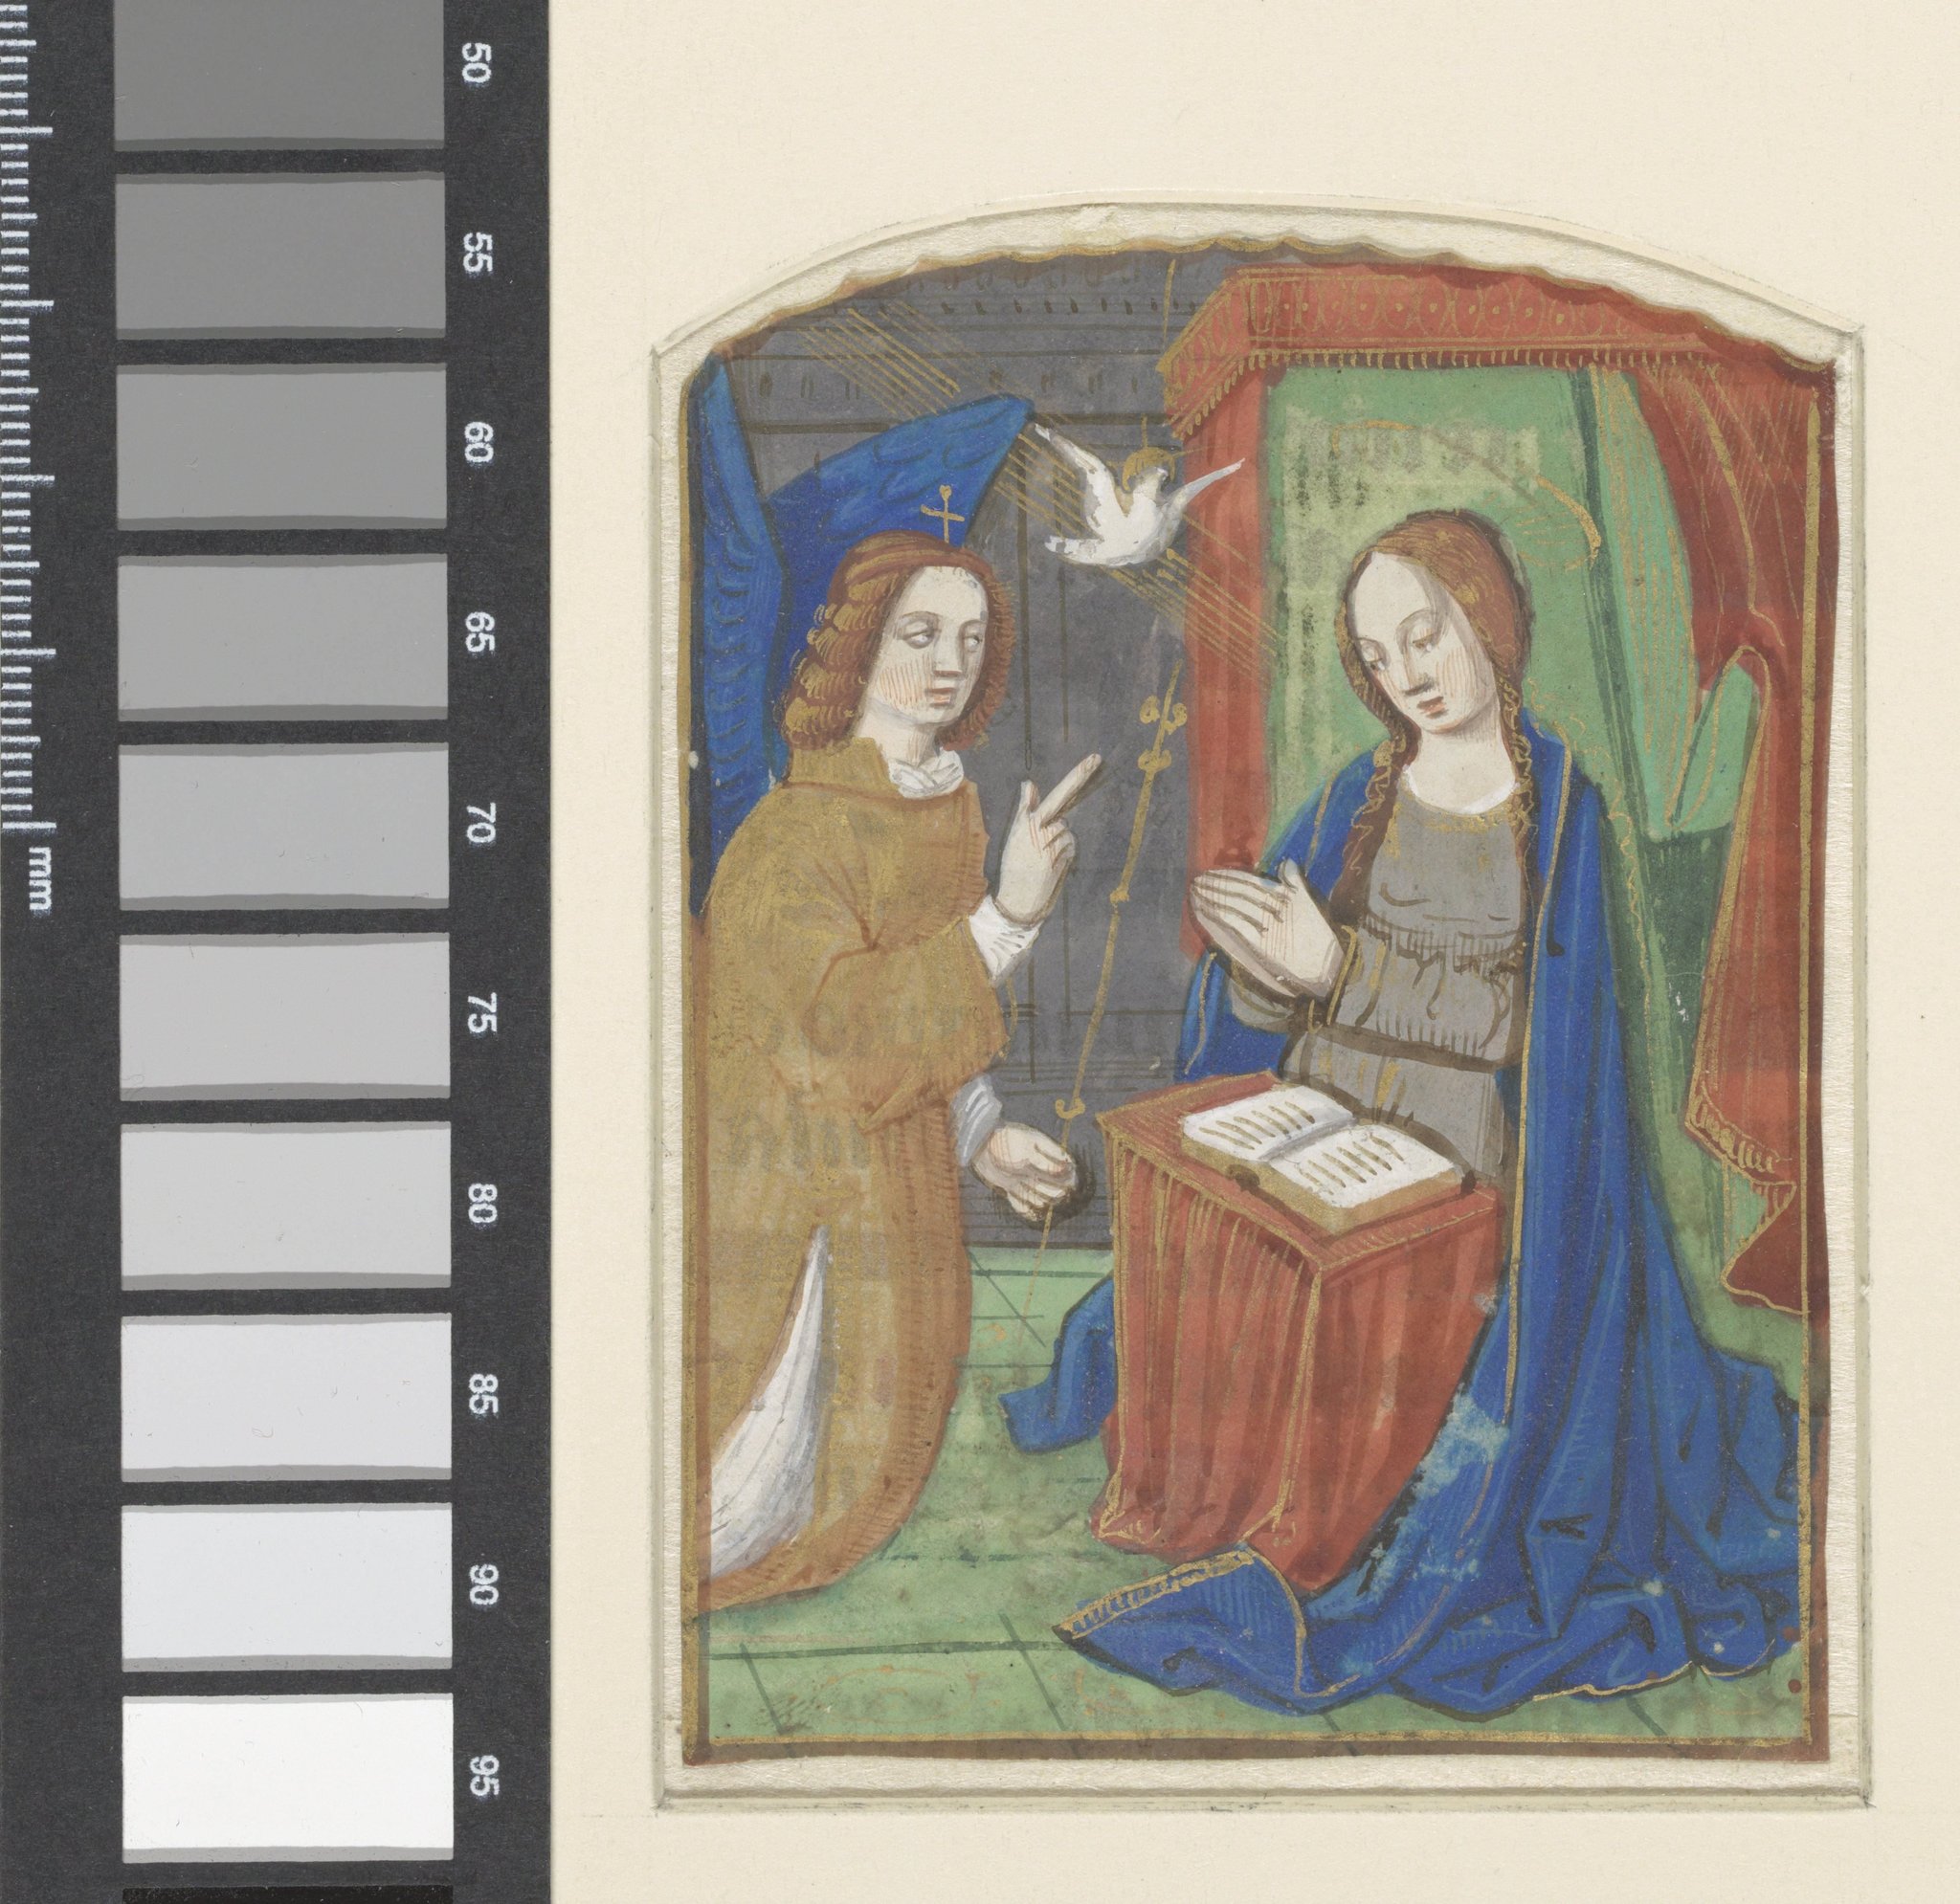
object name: drawing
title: Miniatuur uit een getijdenboek: verkondiging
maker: Anonymous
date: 1475-1500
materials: paint, gold leaf, parchment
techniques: brush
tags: the annunciation: mary kneeling